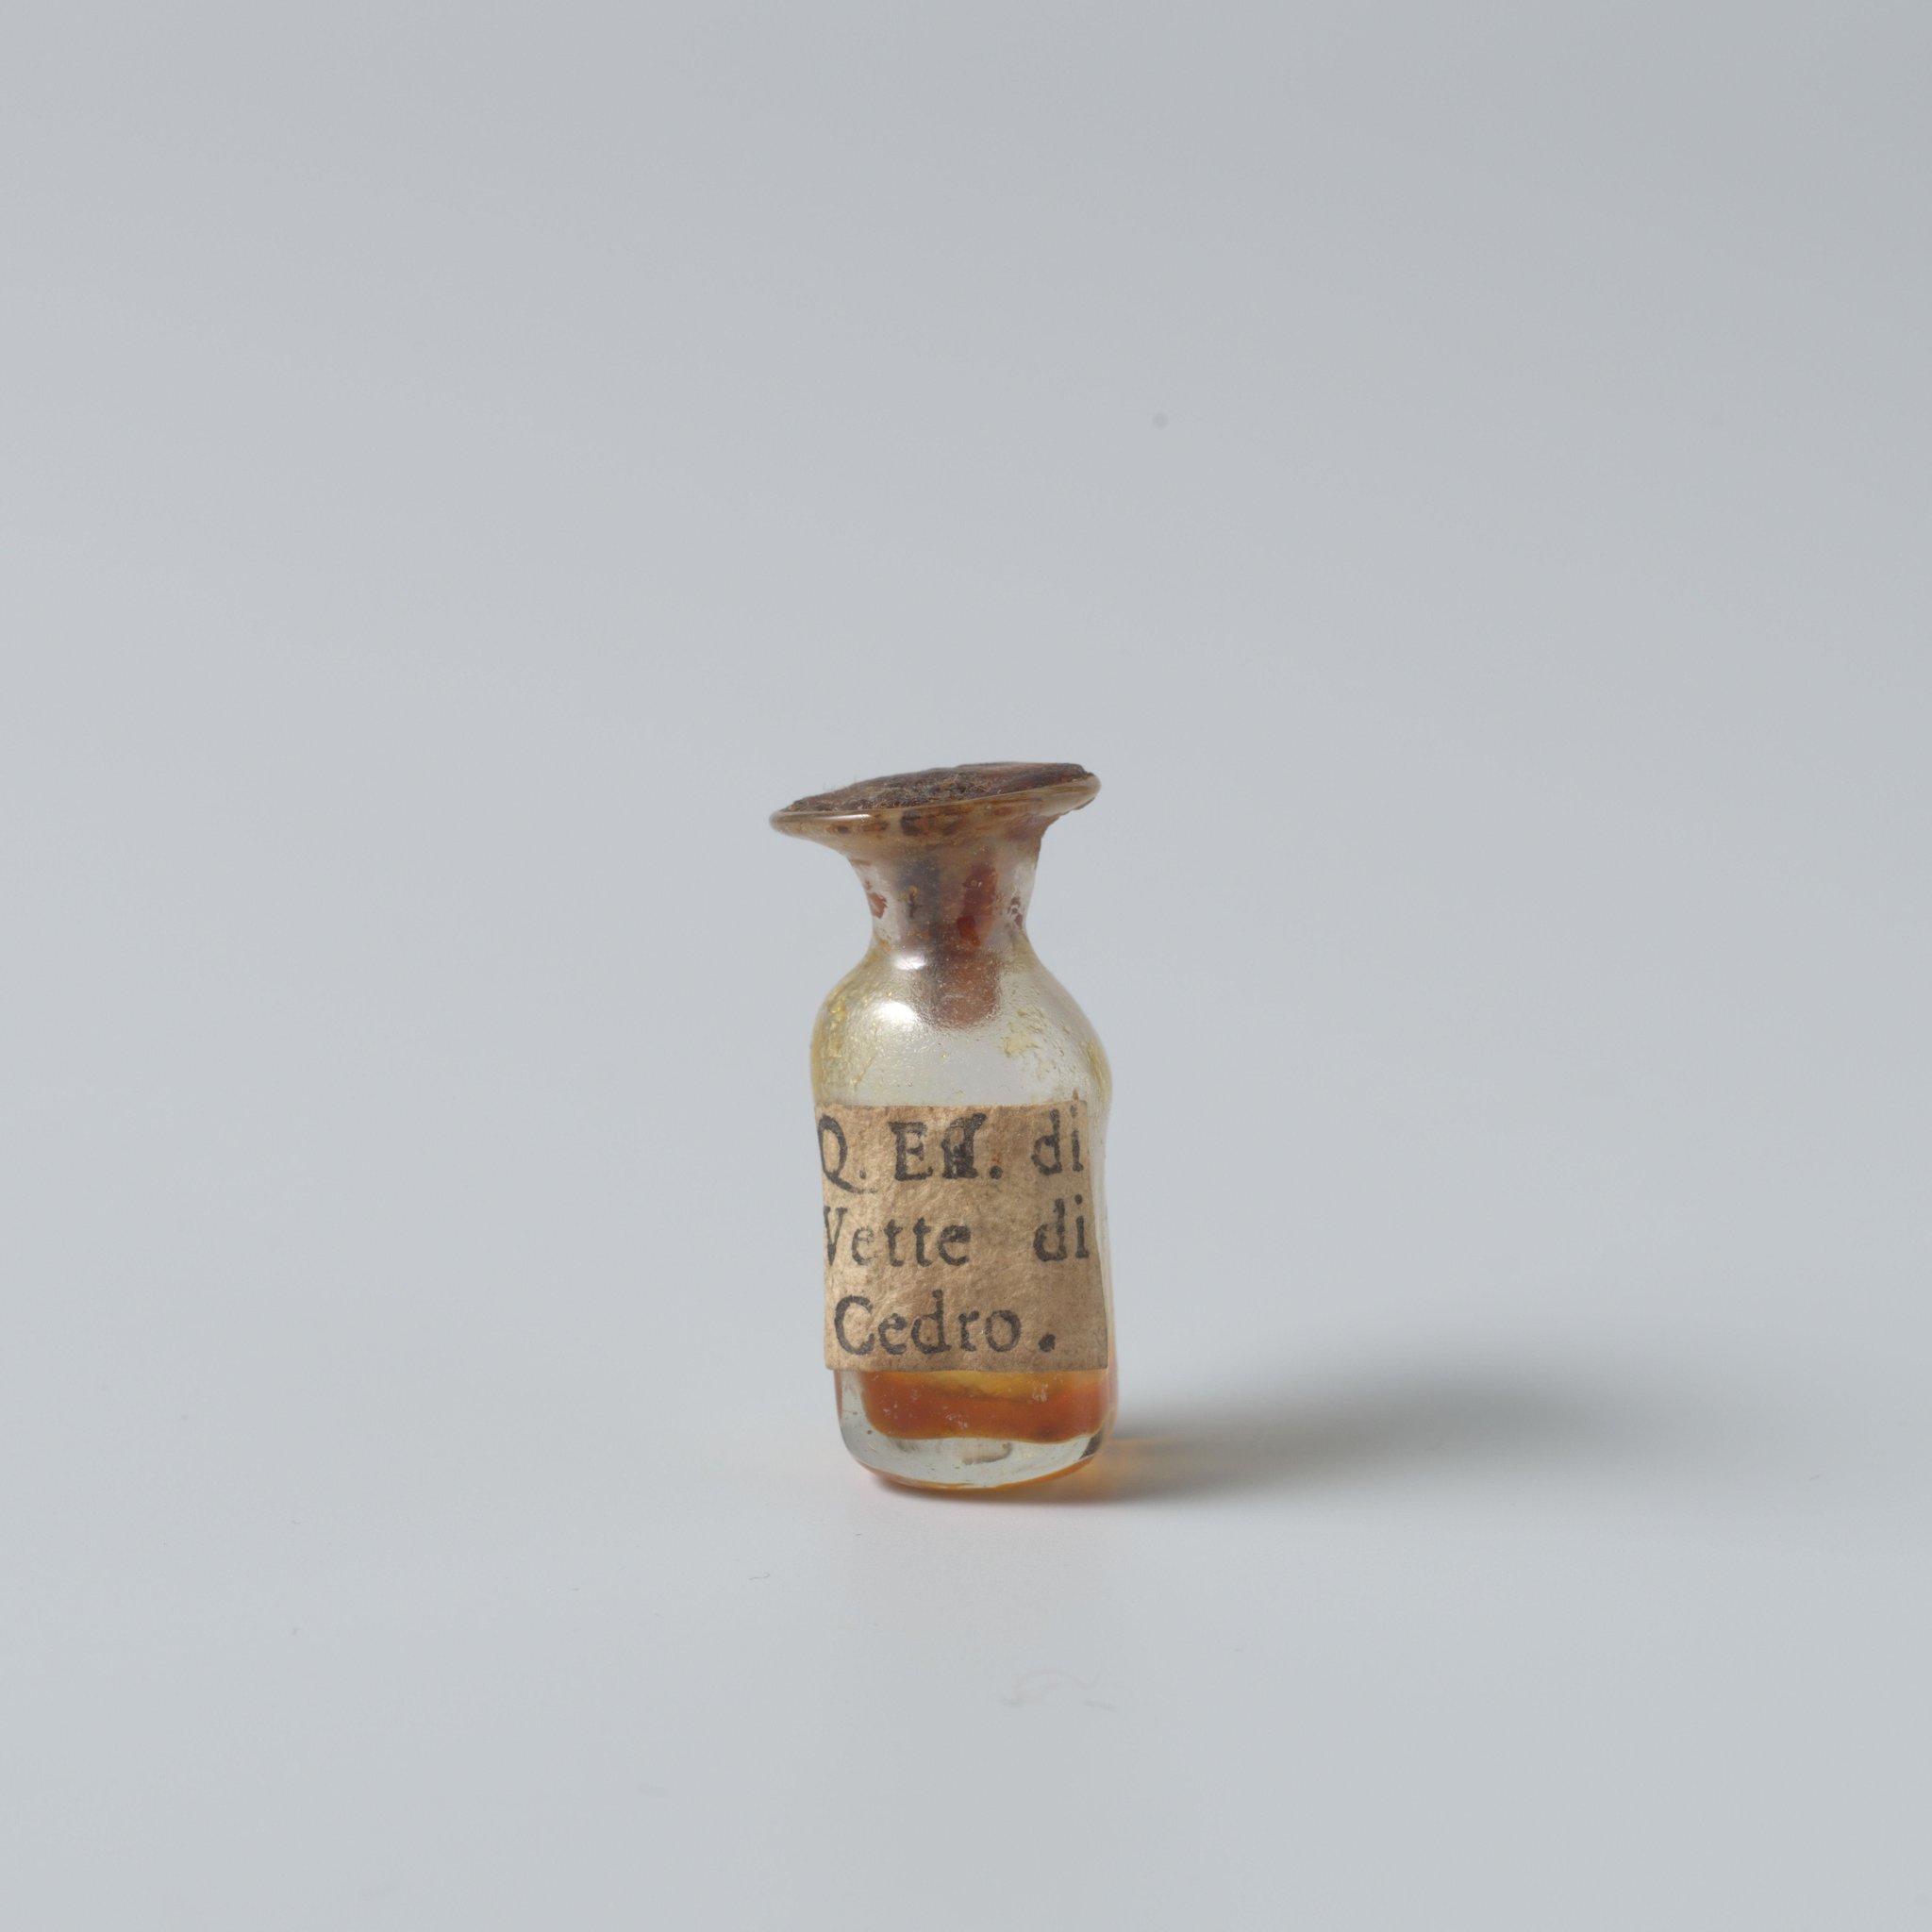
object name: miniature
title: Voorraadfles met vierkant lichaam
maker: Anonymous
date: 1700-1799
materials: glass, wax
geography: netherlands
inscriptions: inscription: ‘Q.Eff.di Vette di Cedro’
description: Voorraadfles van helder kleurloos glas, vierkant lichaam met hals en ronde wijduitstaande mondrand. De fles draagt een etiket met het opschrift: 'Q.Eff.di Vette di Cedro'. In de fles resten van een vettige substantie. De fles is afgedicht met een prop was.